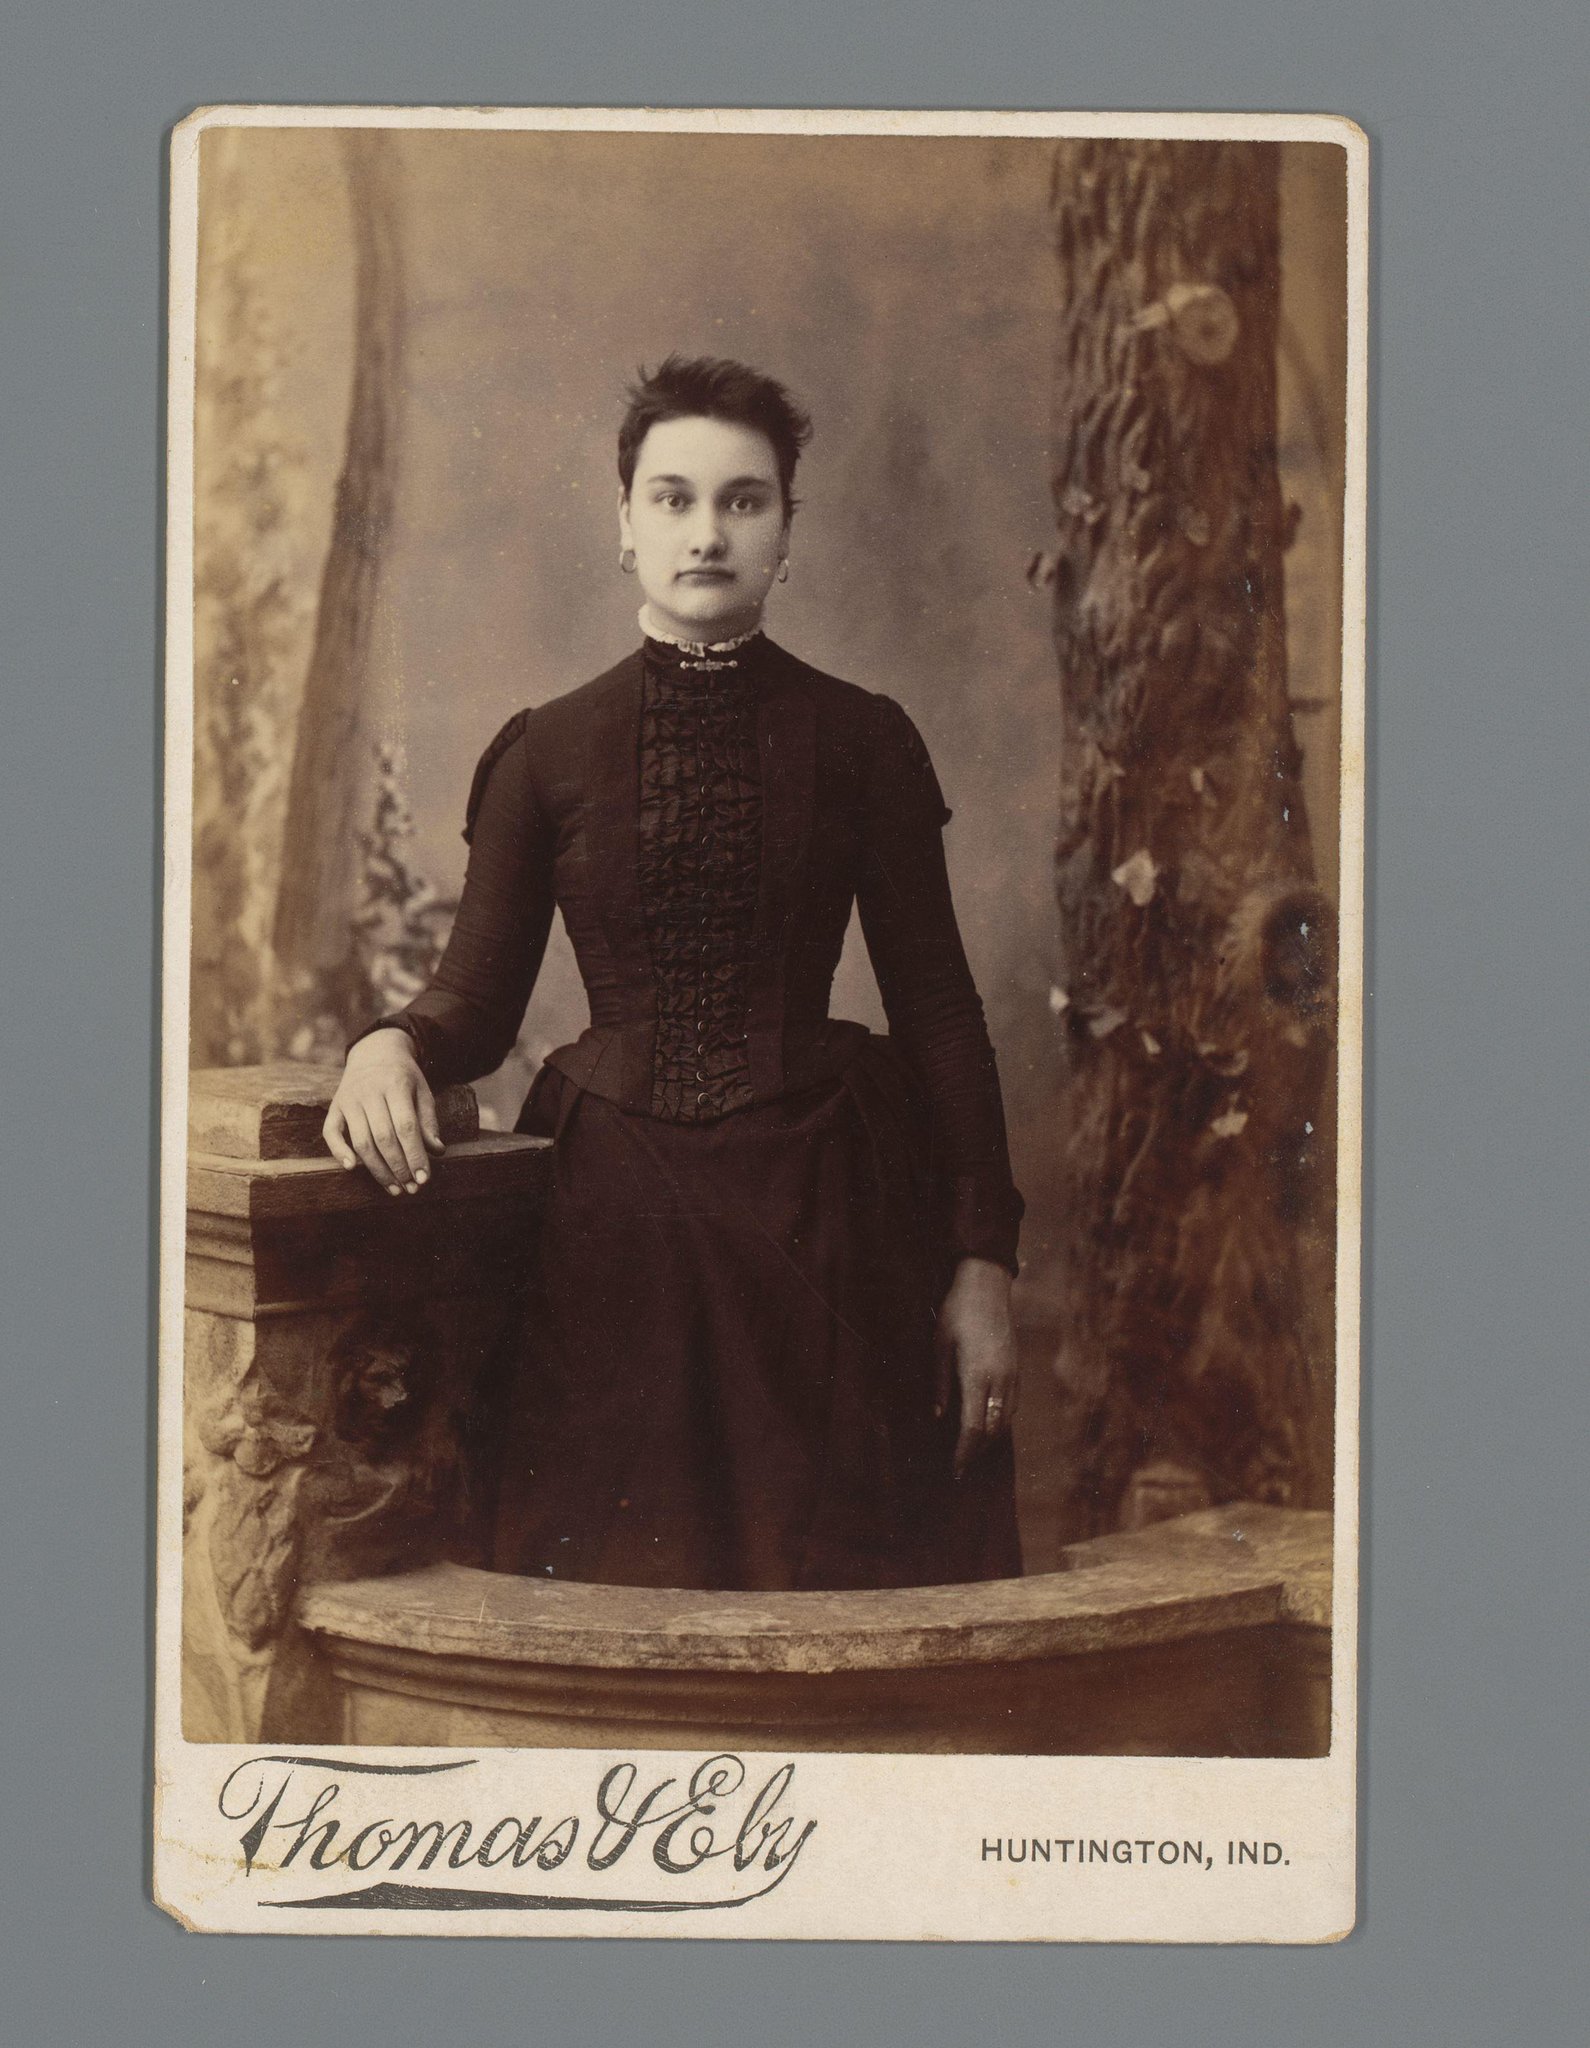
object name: cabinet photograph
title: Portret van een onbekende jonge vrouw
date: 1866-1900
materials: cardboard, paper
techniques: albumen print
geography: huntington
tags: adolescent, young woman, maiden, anonymous historical person portrayed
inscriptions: number: ‘700 1800’